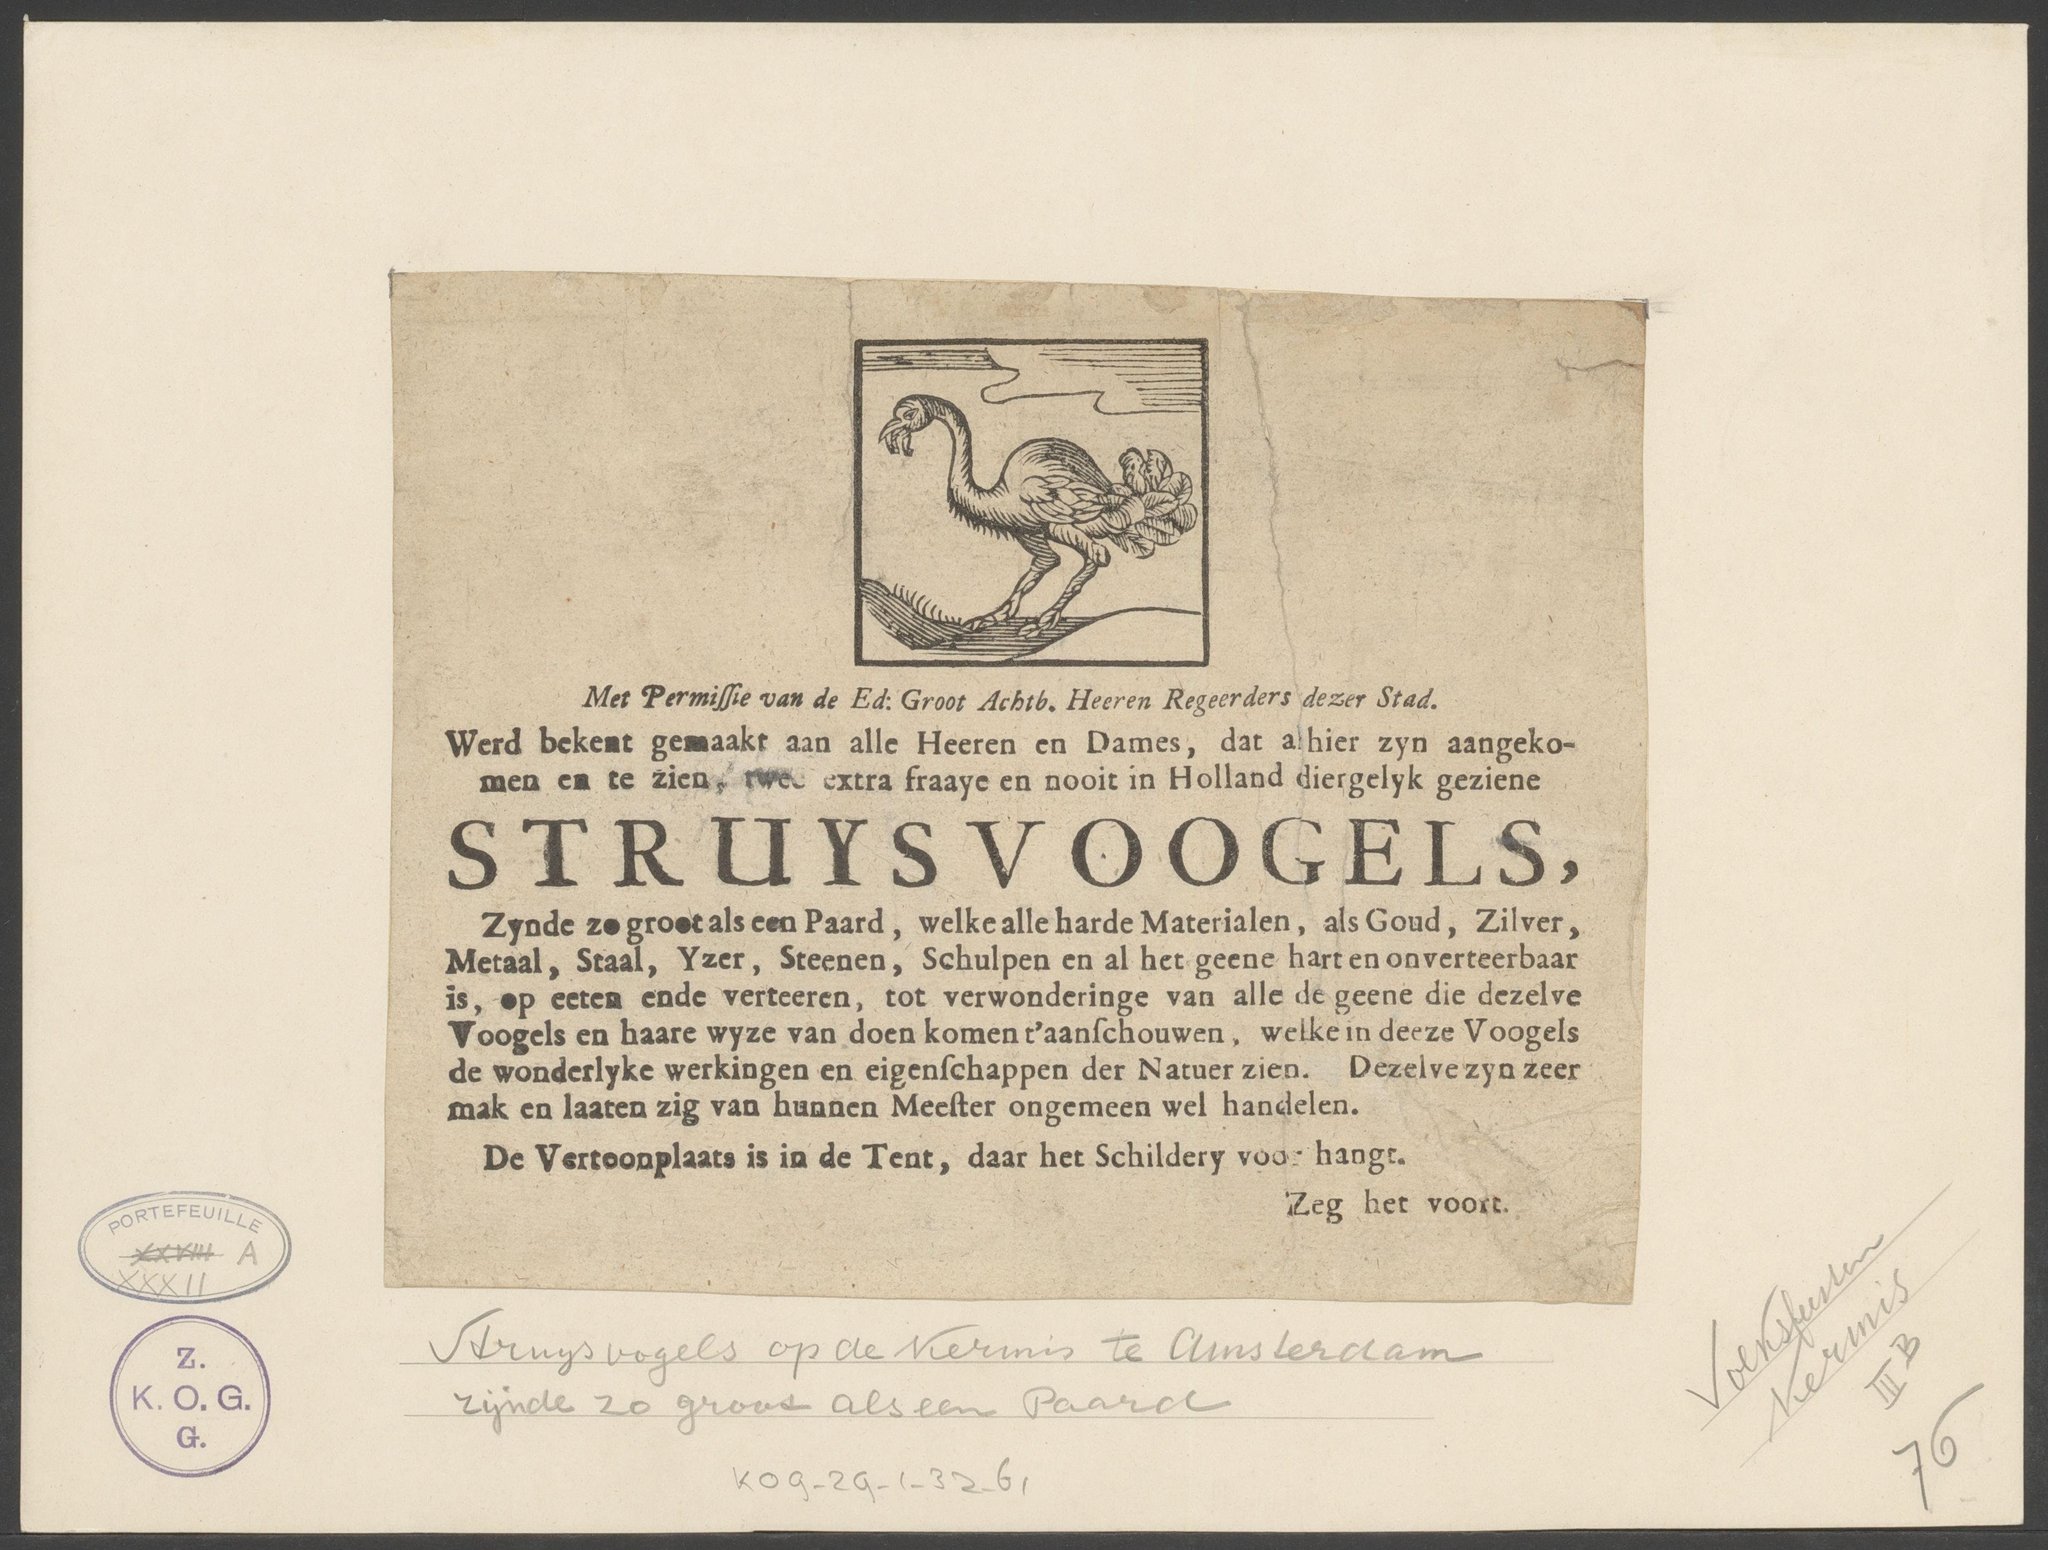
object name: print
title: Struysvoogels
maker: Anonymous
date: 1807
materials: paper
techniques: letterpress printing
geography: netherlands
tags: circus animals, walker and runner birds: ostrich, circus performance with trained animals (monkeys, elephants, bears, lions and tigers, horses, dogs, dolphins, seals, fleas), pleasure fair and circus, amsterdam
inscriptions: collector's mark: Lugt 1641, collector's mark